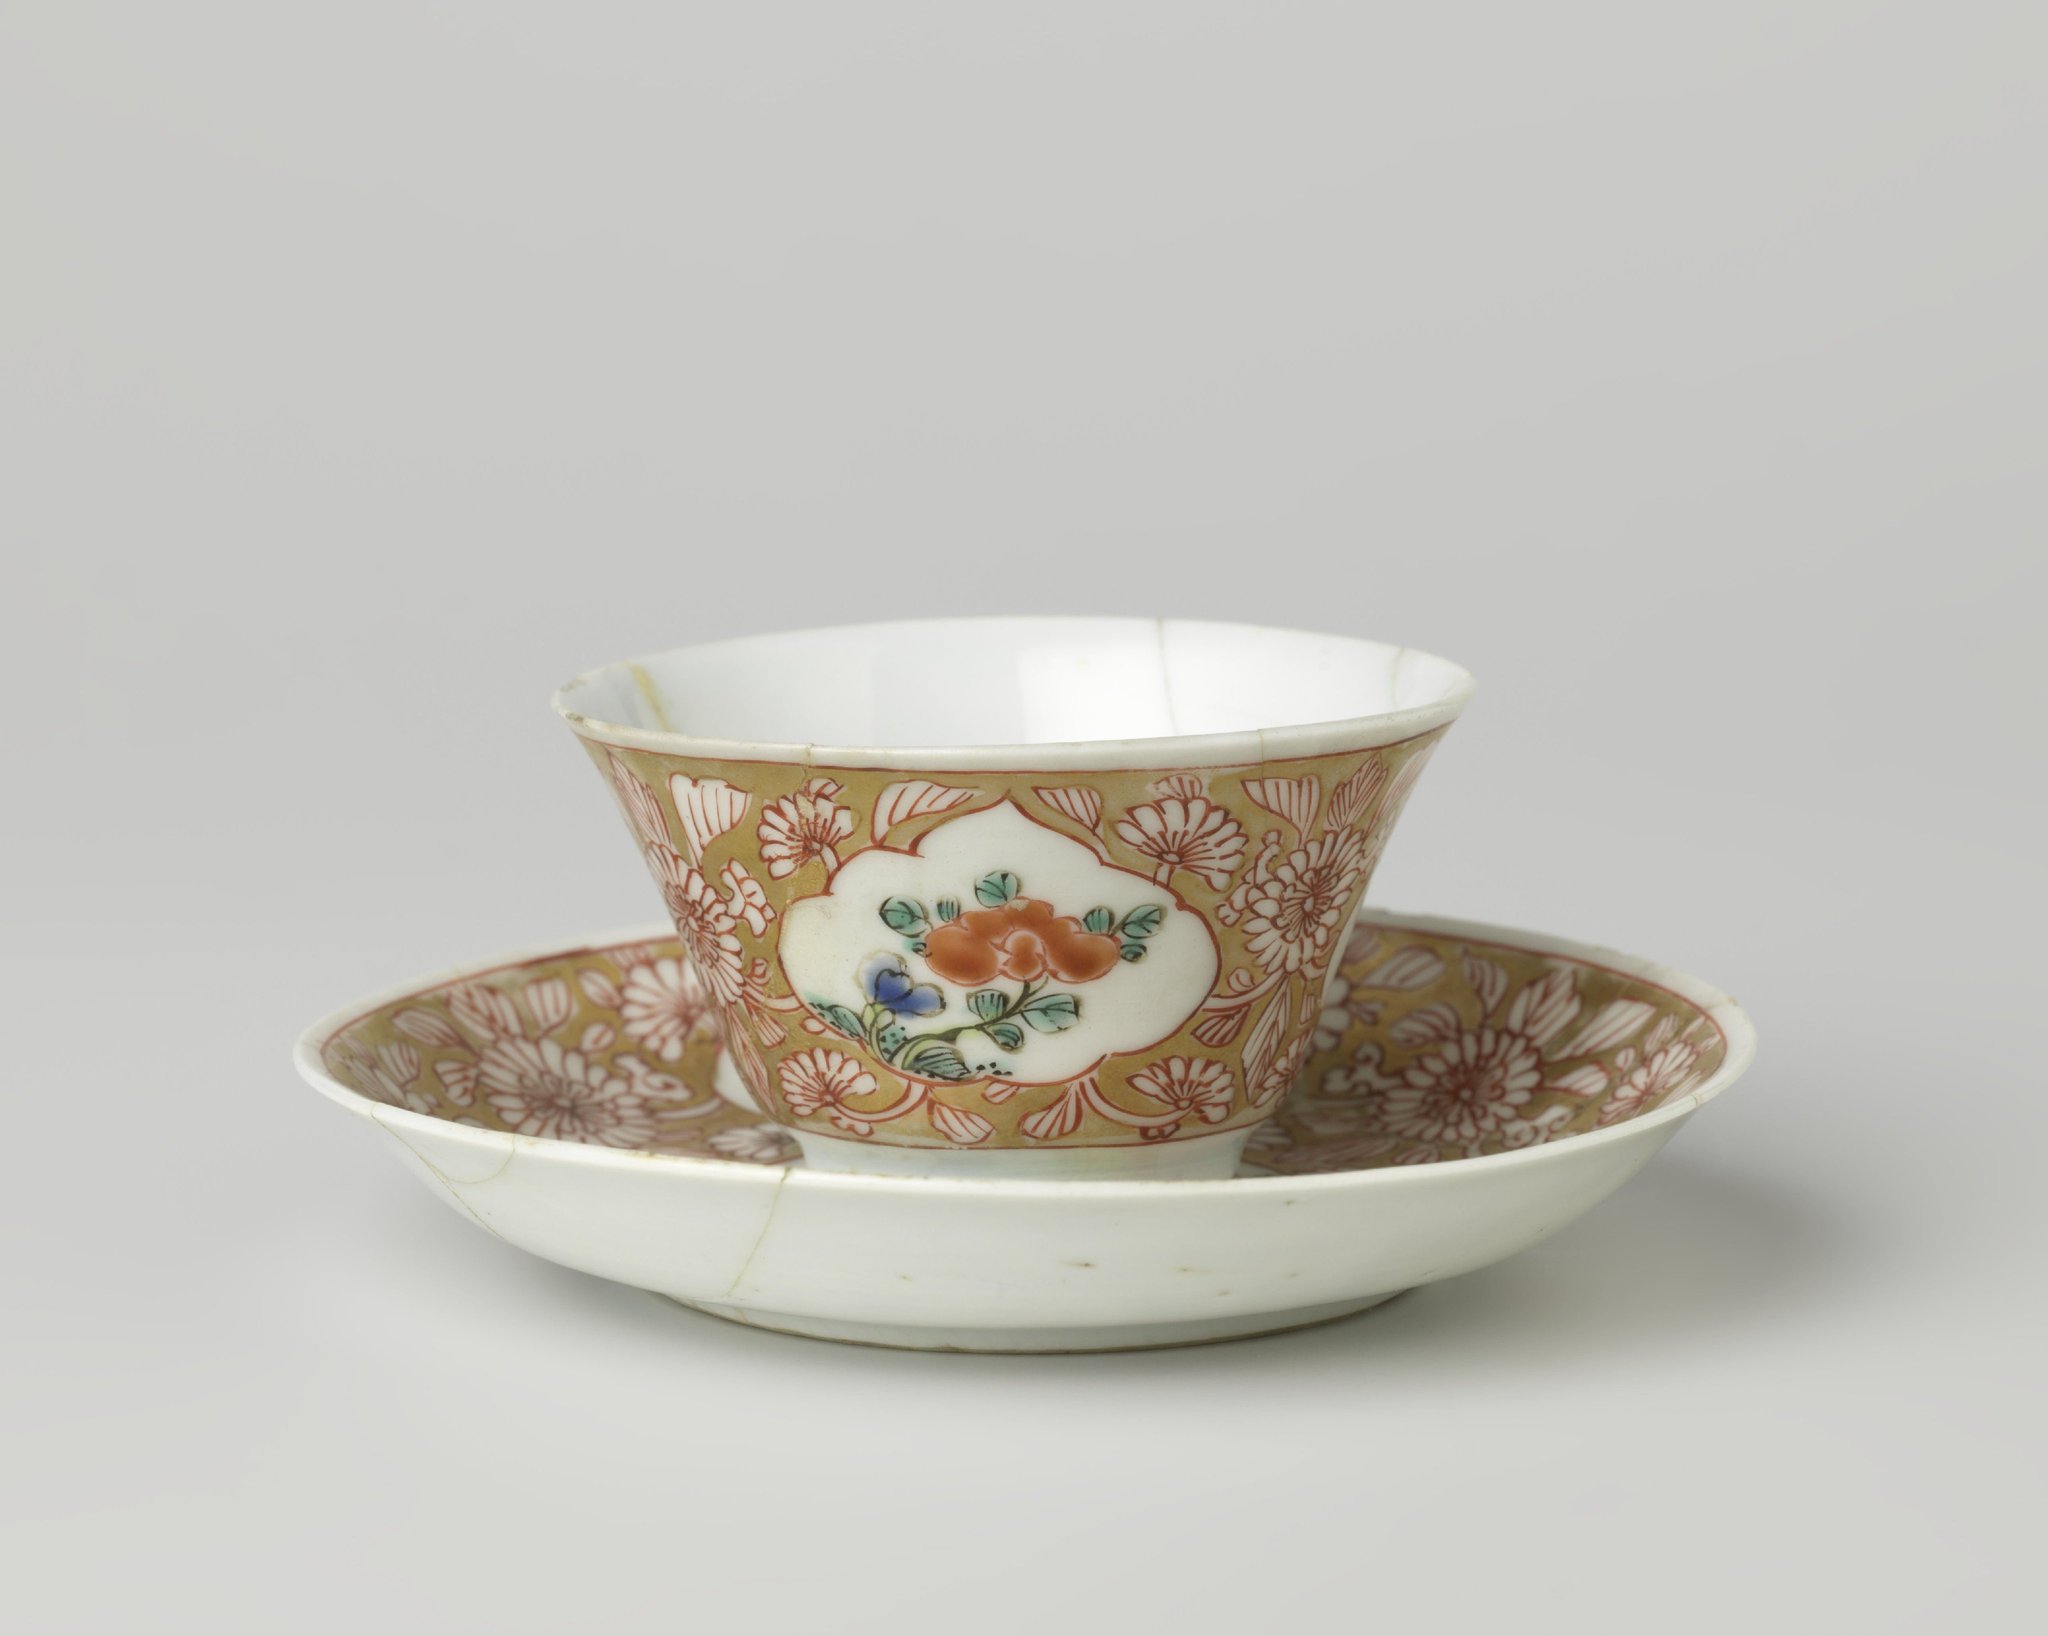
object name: kop en schotel, kop en schotel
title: Cup and saucer with a woman with flower basket and flowering plants in panels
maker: Anonymous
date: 1725-1749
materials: glaze, gold, paint, porcelain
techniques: firing, gilding, turning, vitrification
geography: china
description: Kop en schotel van porselein met spreidende wand, beschilderd op het glazuur in blauw, rood, roze, groen, zwart en goud. Op het plat van de schotel een medaillon met een vrouw in een landschap met een bloemenmand; om het medaillon uitgespaarde bloemranken en drie cartouches met bloeiende planten (o.a. lotus) in een gouden grond. Schotel en kop zijn gebroken geweest. Famille rose.